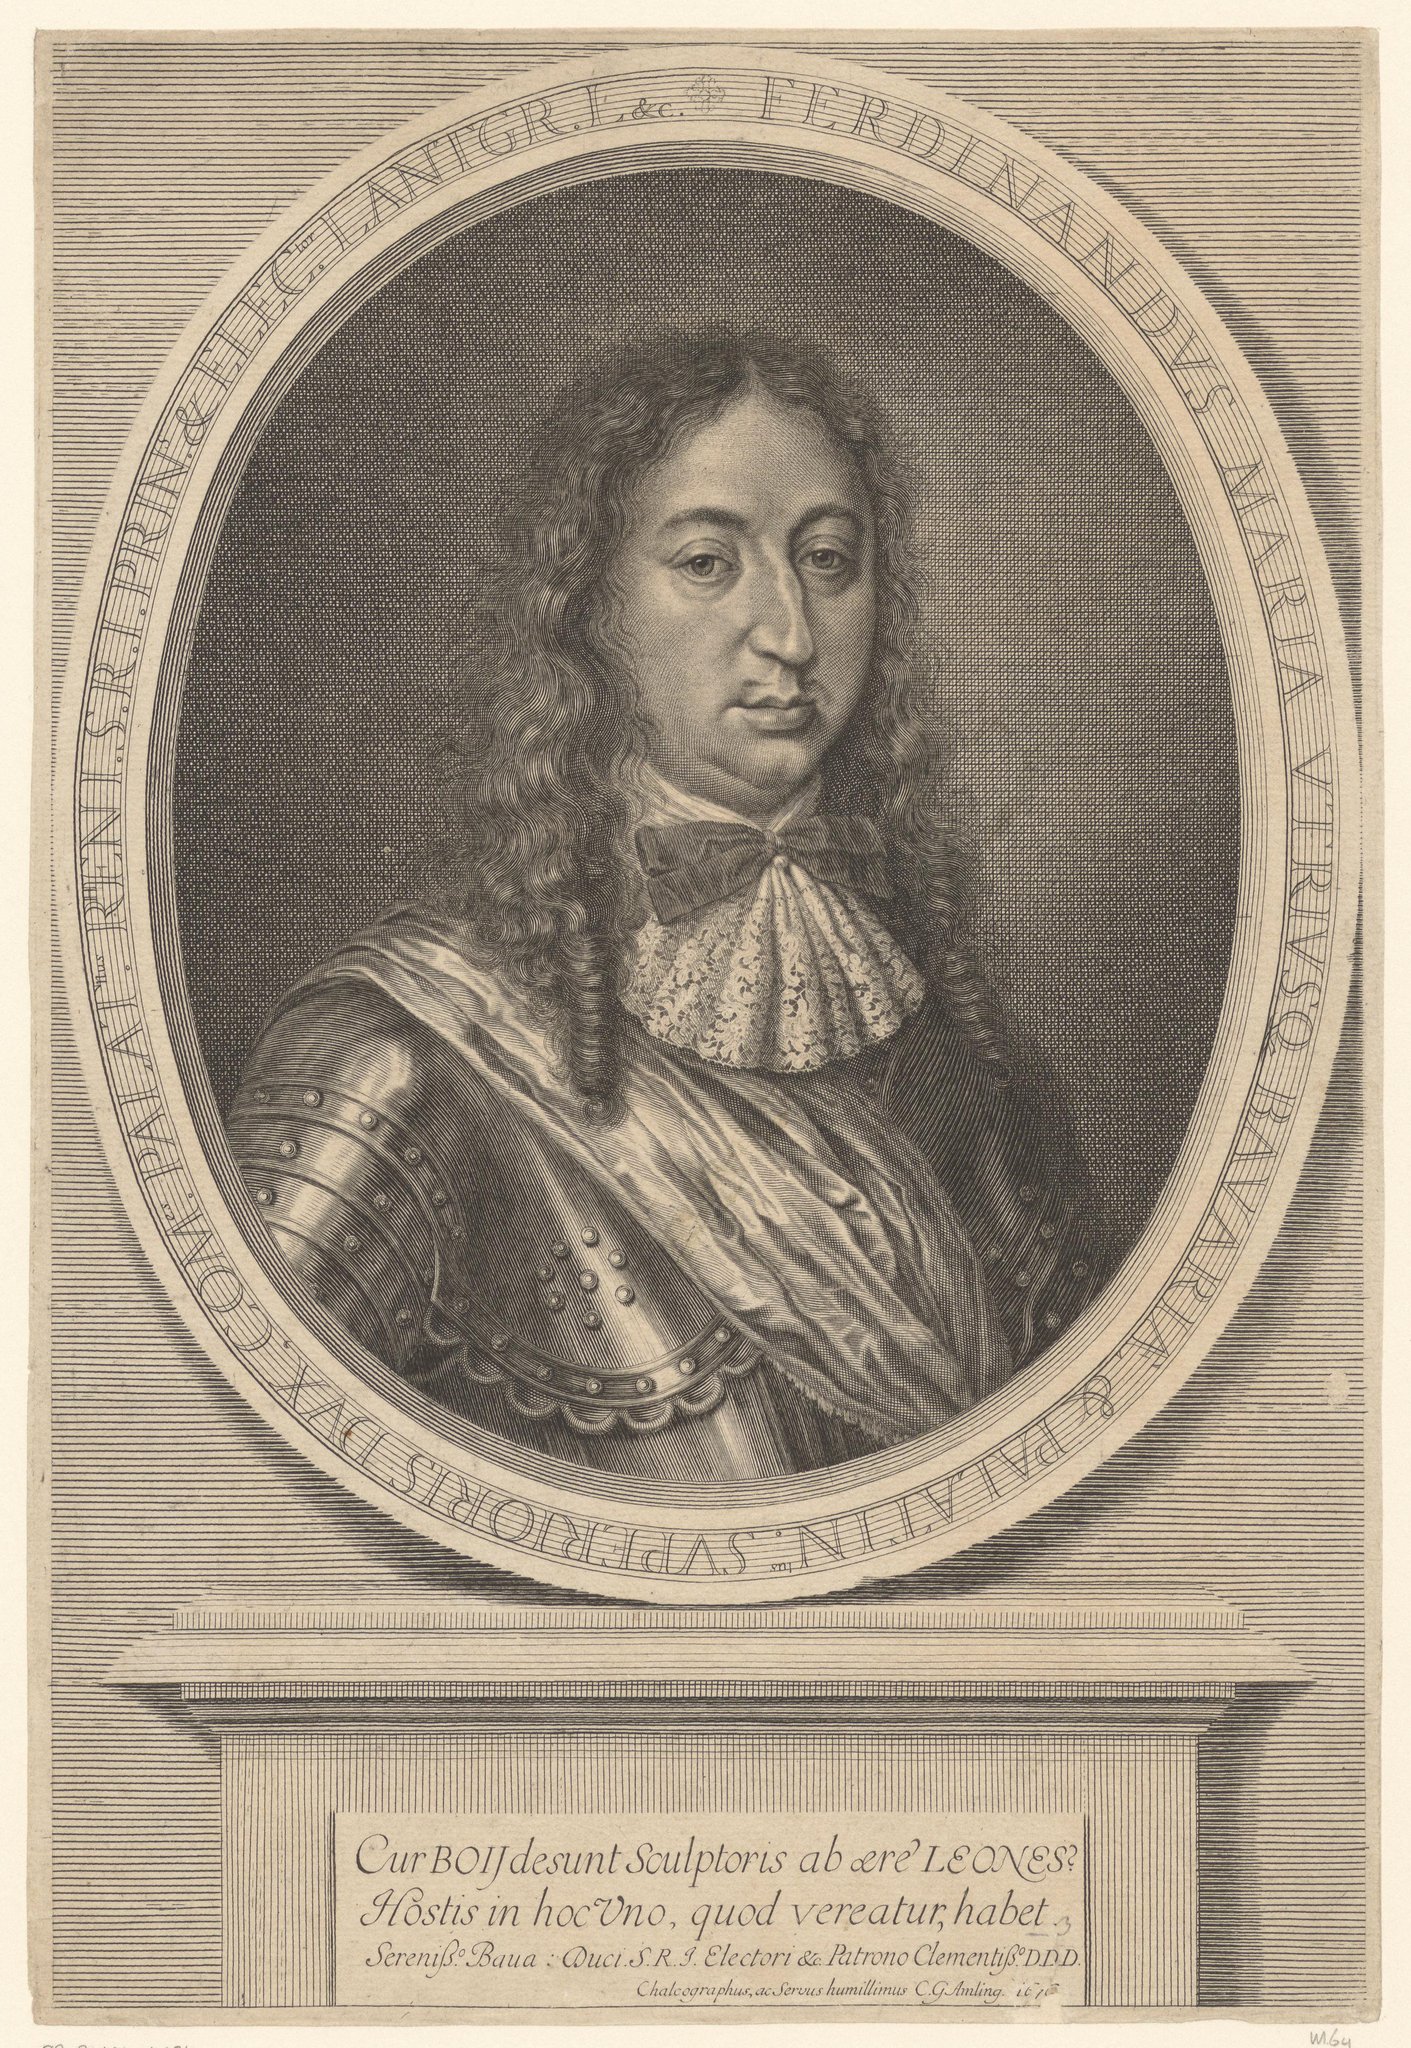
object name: print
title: Portret van Ferdinand Maria van Beieren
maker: karl gustav amling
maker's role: print maker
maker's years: 1651-1702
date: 1676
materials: paper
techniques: engraving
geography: munich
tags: ferdinand maria keurvorst van beieren, historical persons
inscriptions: collector's mark: Lugt 2228